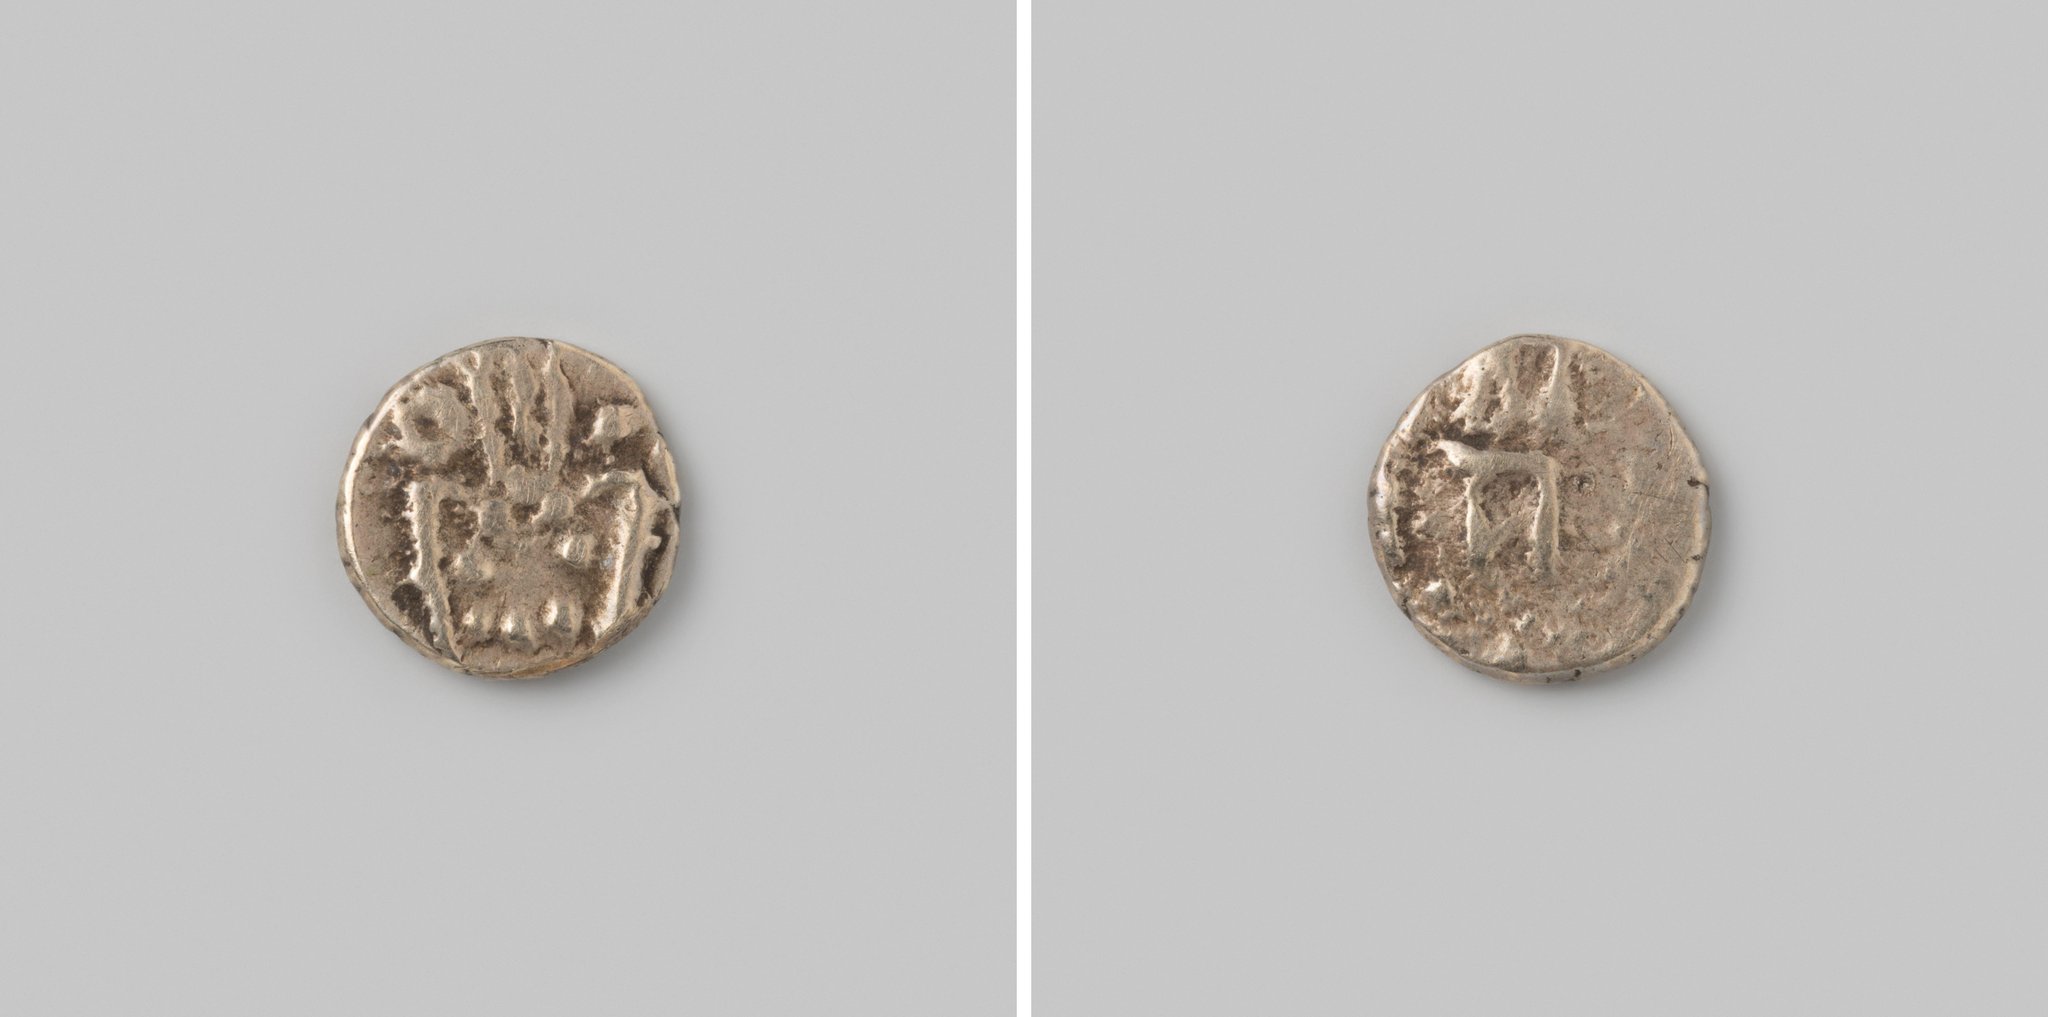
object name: coin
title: Fanam van de raja's van Coorg [?] in India,1687-1834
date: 1687-1834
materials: silver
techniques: striking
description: goud-zilveren munt. Voorzijde: vira raya-beeltenis. Keerzijde: ondetermineerbare lettertekens.